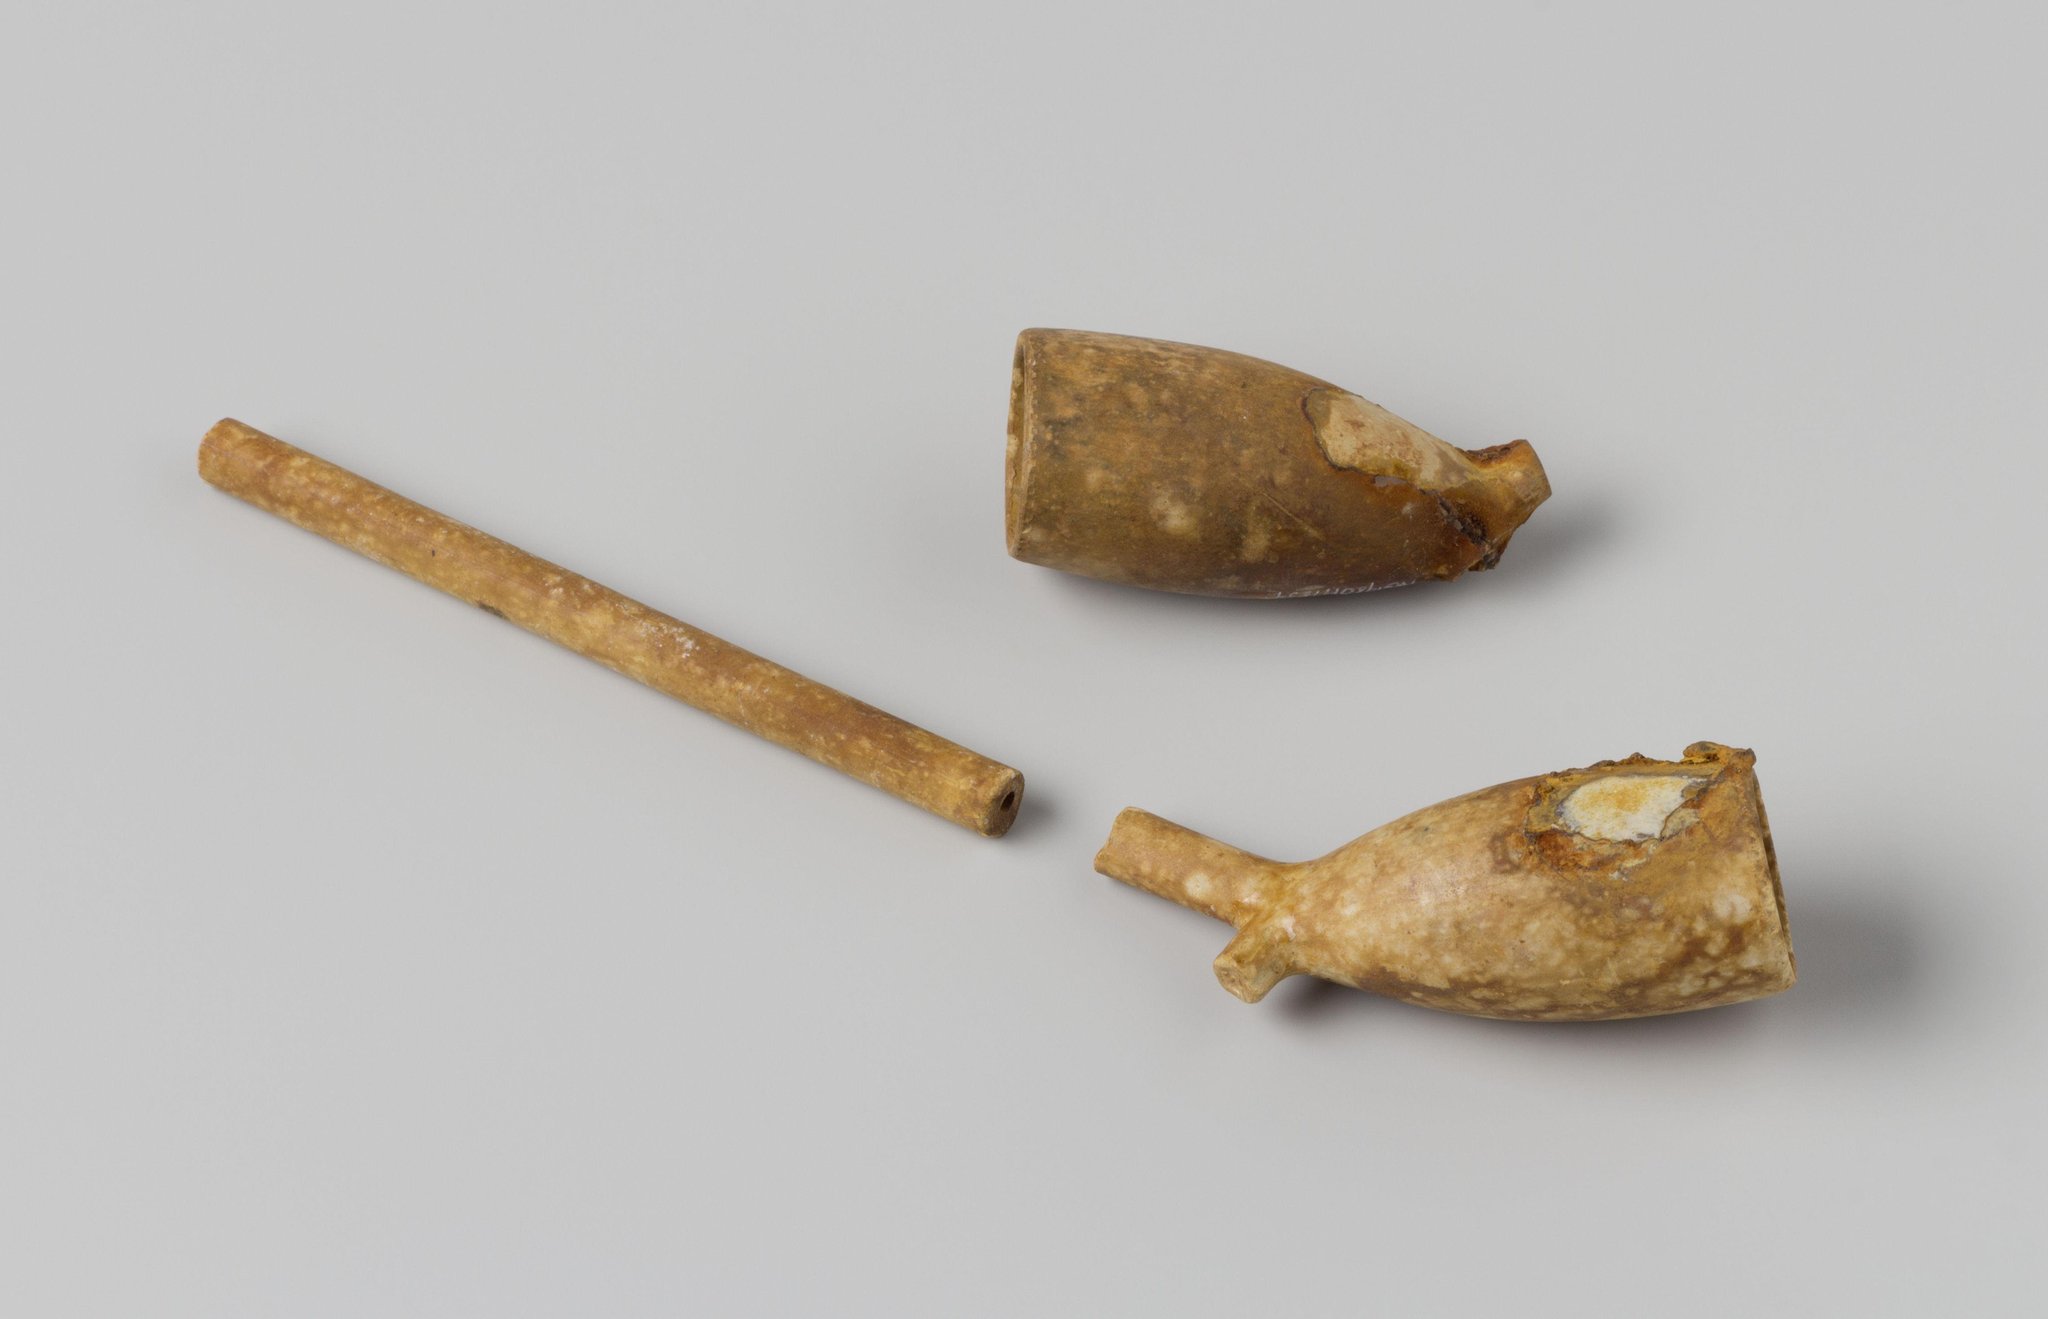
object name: pipe bowl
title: Pijpenkoppen en fragment pijpensteel uit het wrak van de Oost-Indiëvaarder Hollandia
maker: Anonymous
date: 1700-1743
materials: clay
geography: netherlands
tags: verenigde oostindische compagnie, hollandia (schip), annet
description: Pipe, bowl, heelmark: crowned 57; no hsm.